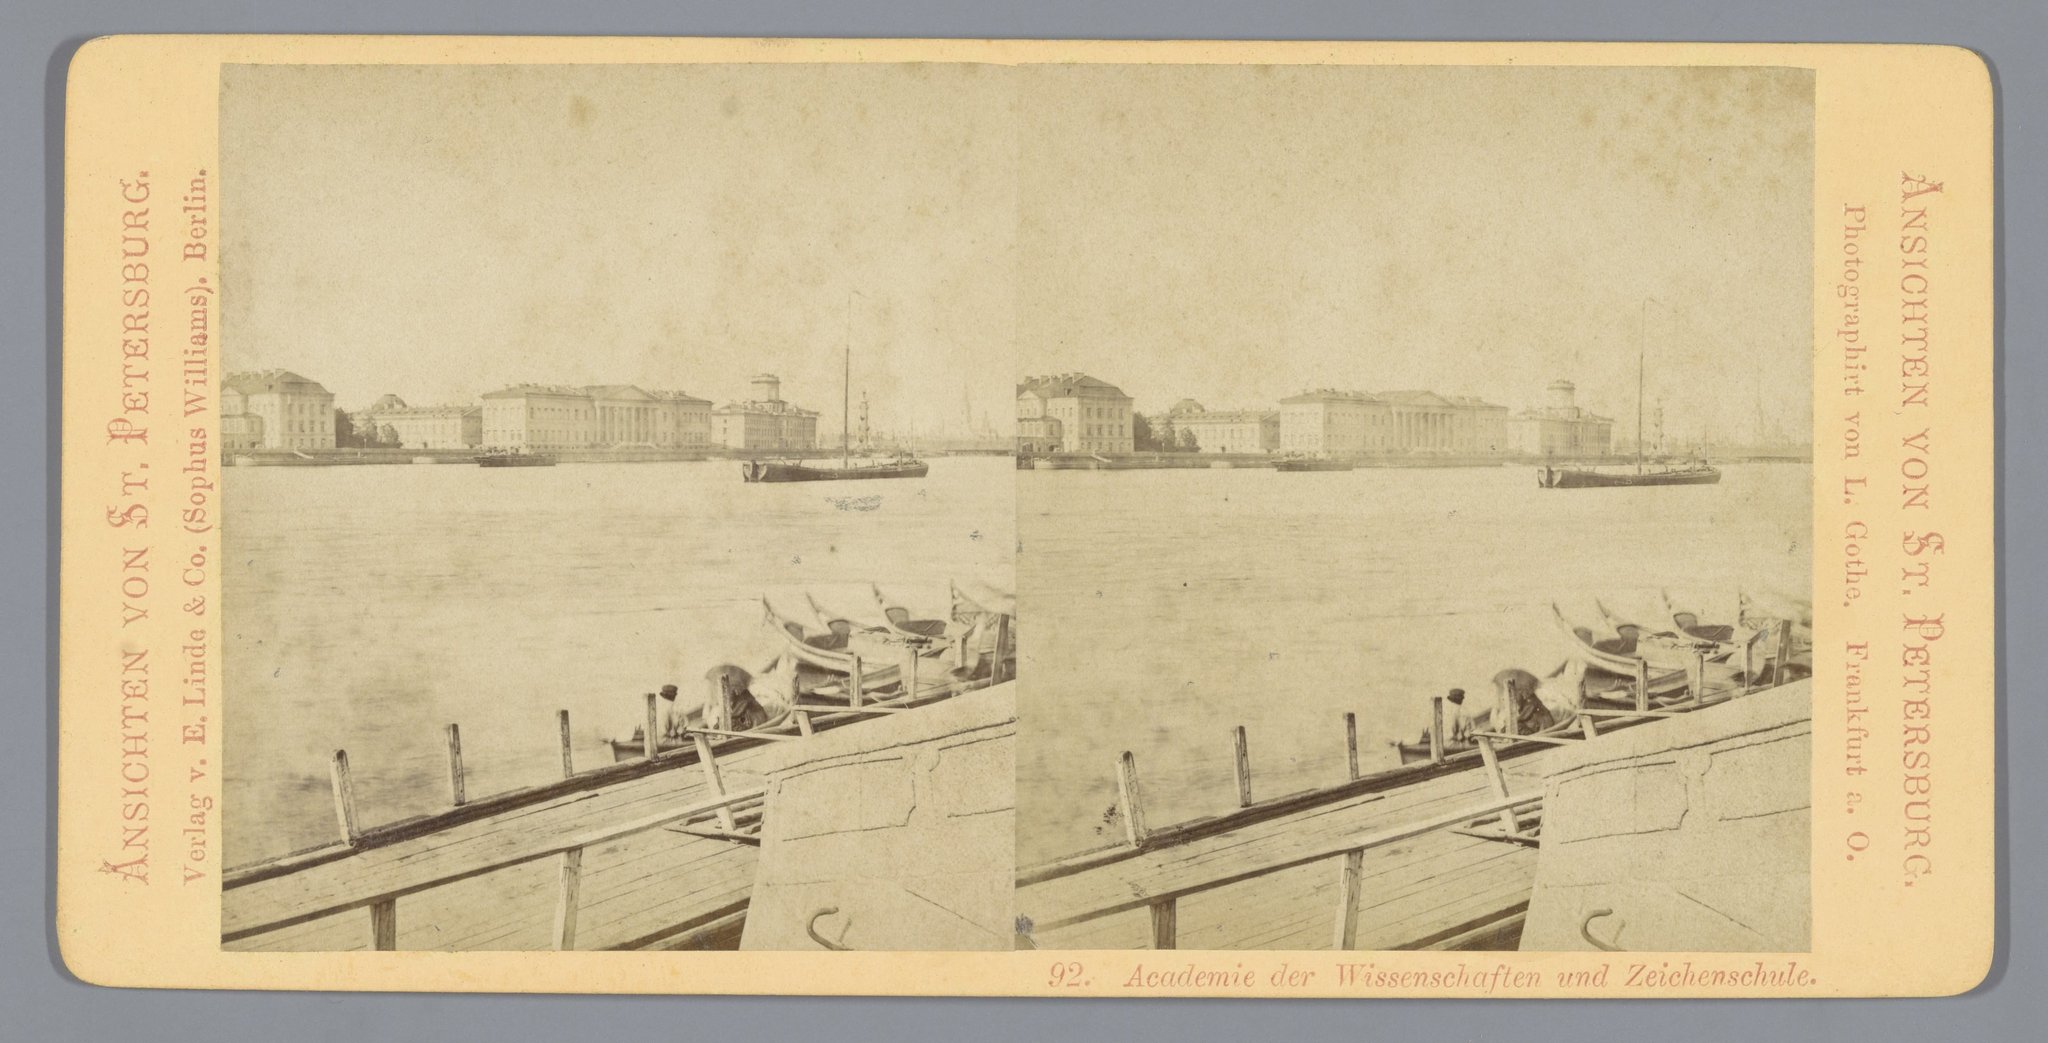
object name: stereograph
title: Gezicht op de Russische Academie van Wetenschappen in Sint-Petersburg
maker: louis gothe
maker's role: fotograaf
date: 1850-1880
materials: cardboard, photographic support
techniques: albumen print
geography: berlin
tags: learned society, academy of sciences, river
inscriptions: number: ‘92.’, inscription: ‘Ansichten von St. Petersburg.’